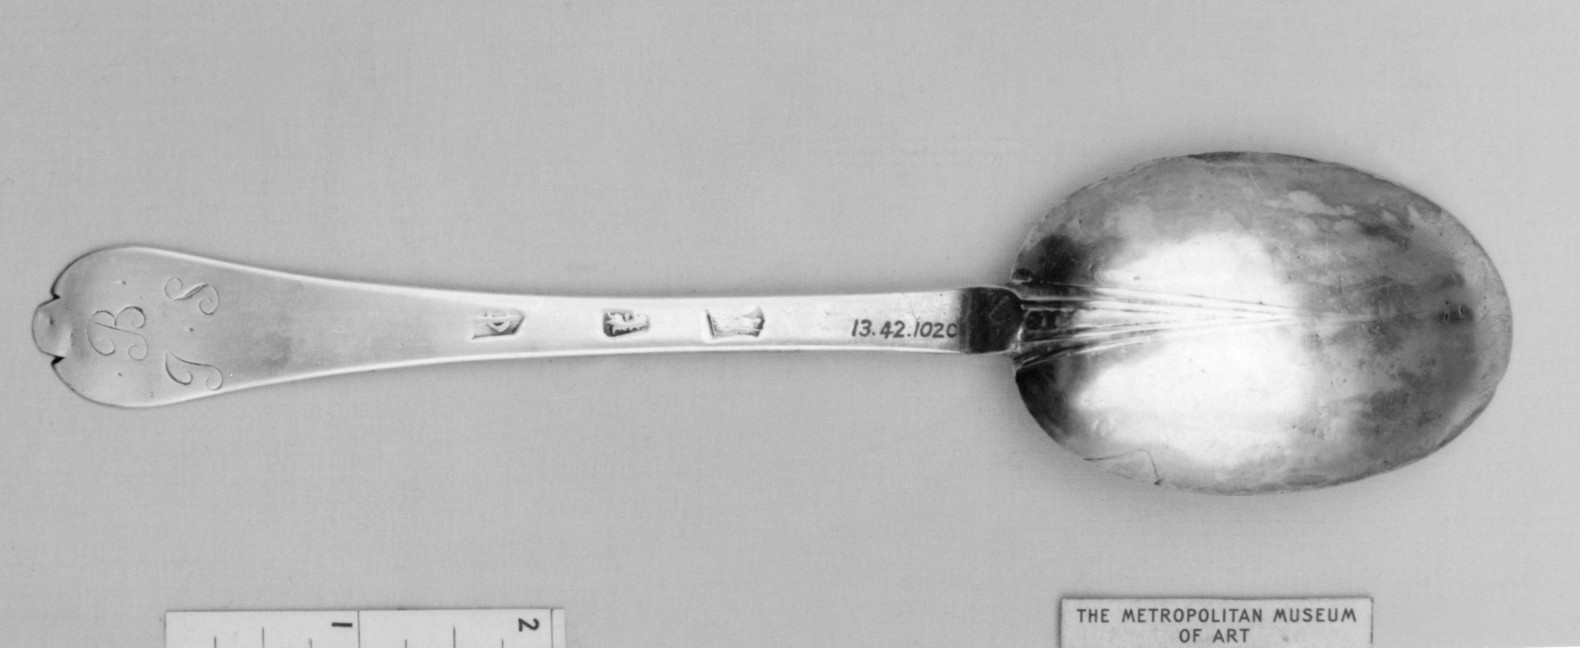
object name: spoon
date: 1698-1699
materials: silver